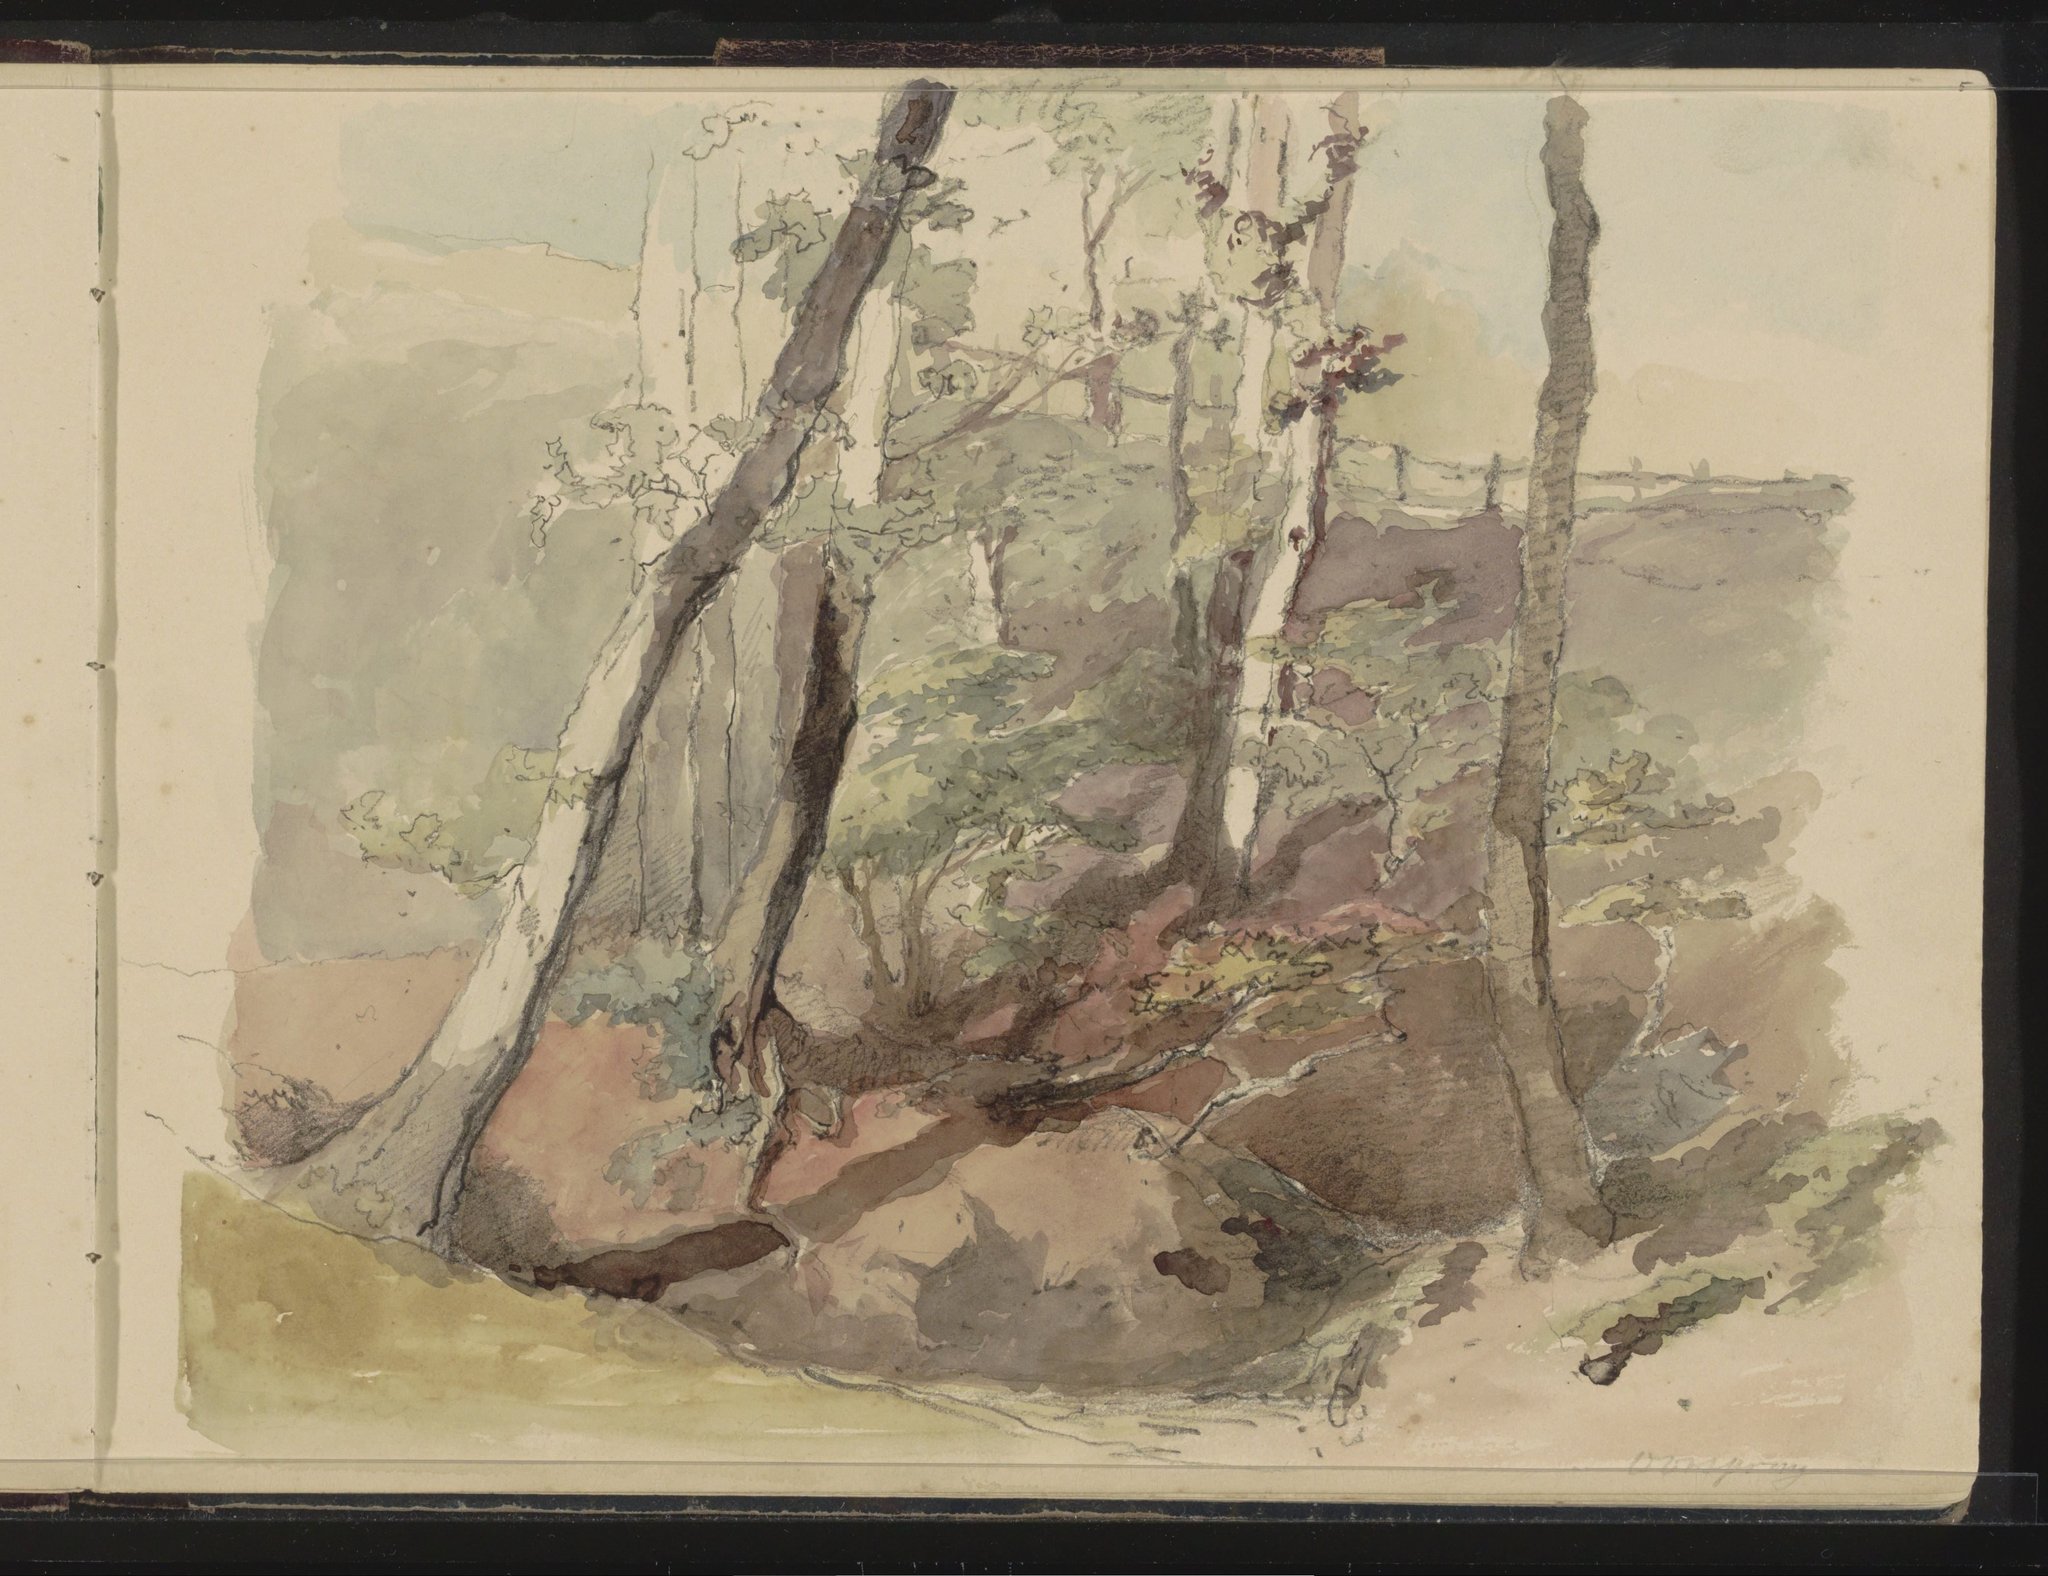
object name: sketchbook leaf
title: Bomen begrensd door een hek op landgoed Hoog Oorsprong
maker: maria vos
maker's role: draughtsman, painter, print maker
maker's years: 1824-1906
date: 1864-1865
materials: paper, pencil, watercolor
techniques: brush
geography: oosterbeek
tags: trees, fence, wall, paling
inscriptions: annotation: ‘Oorsprong’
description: Blad 5 recto uit een schetsboek met 44 bladen.